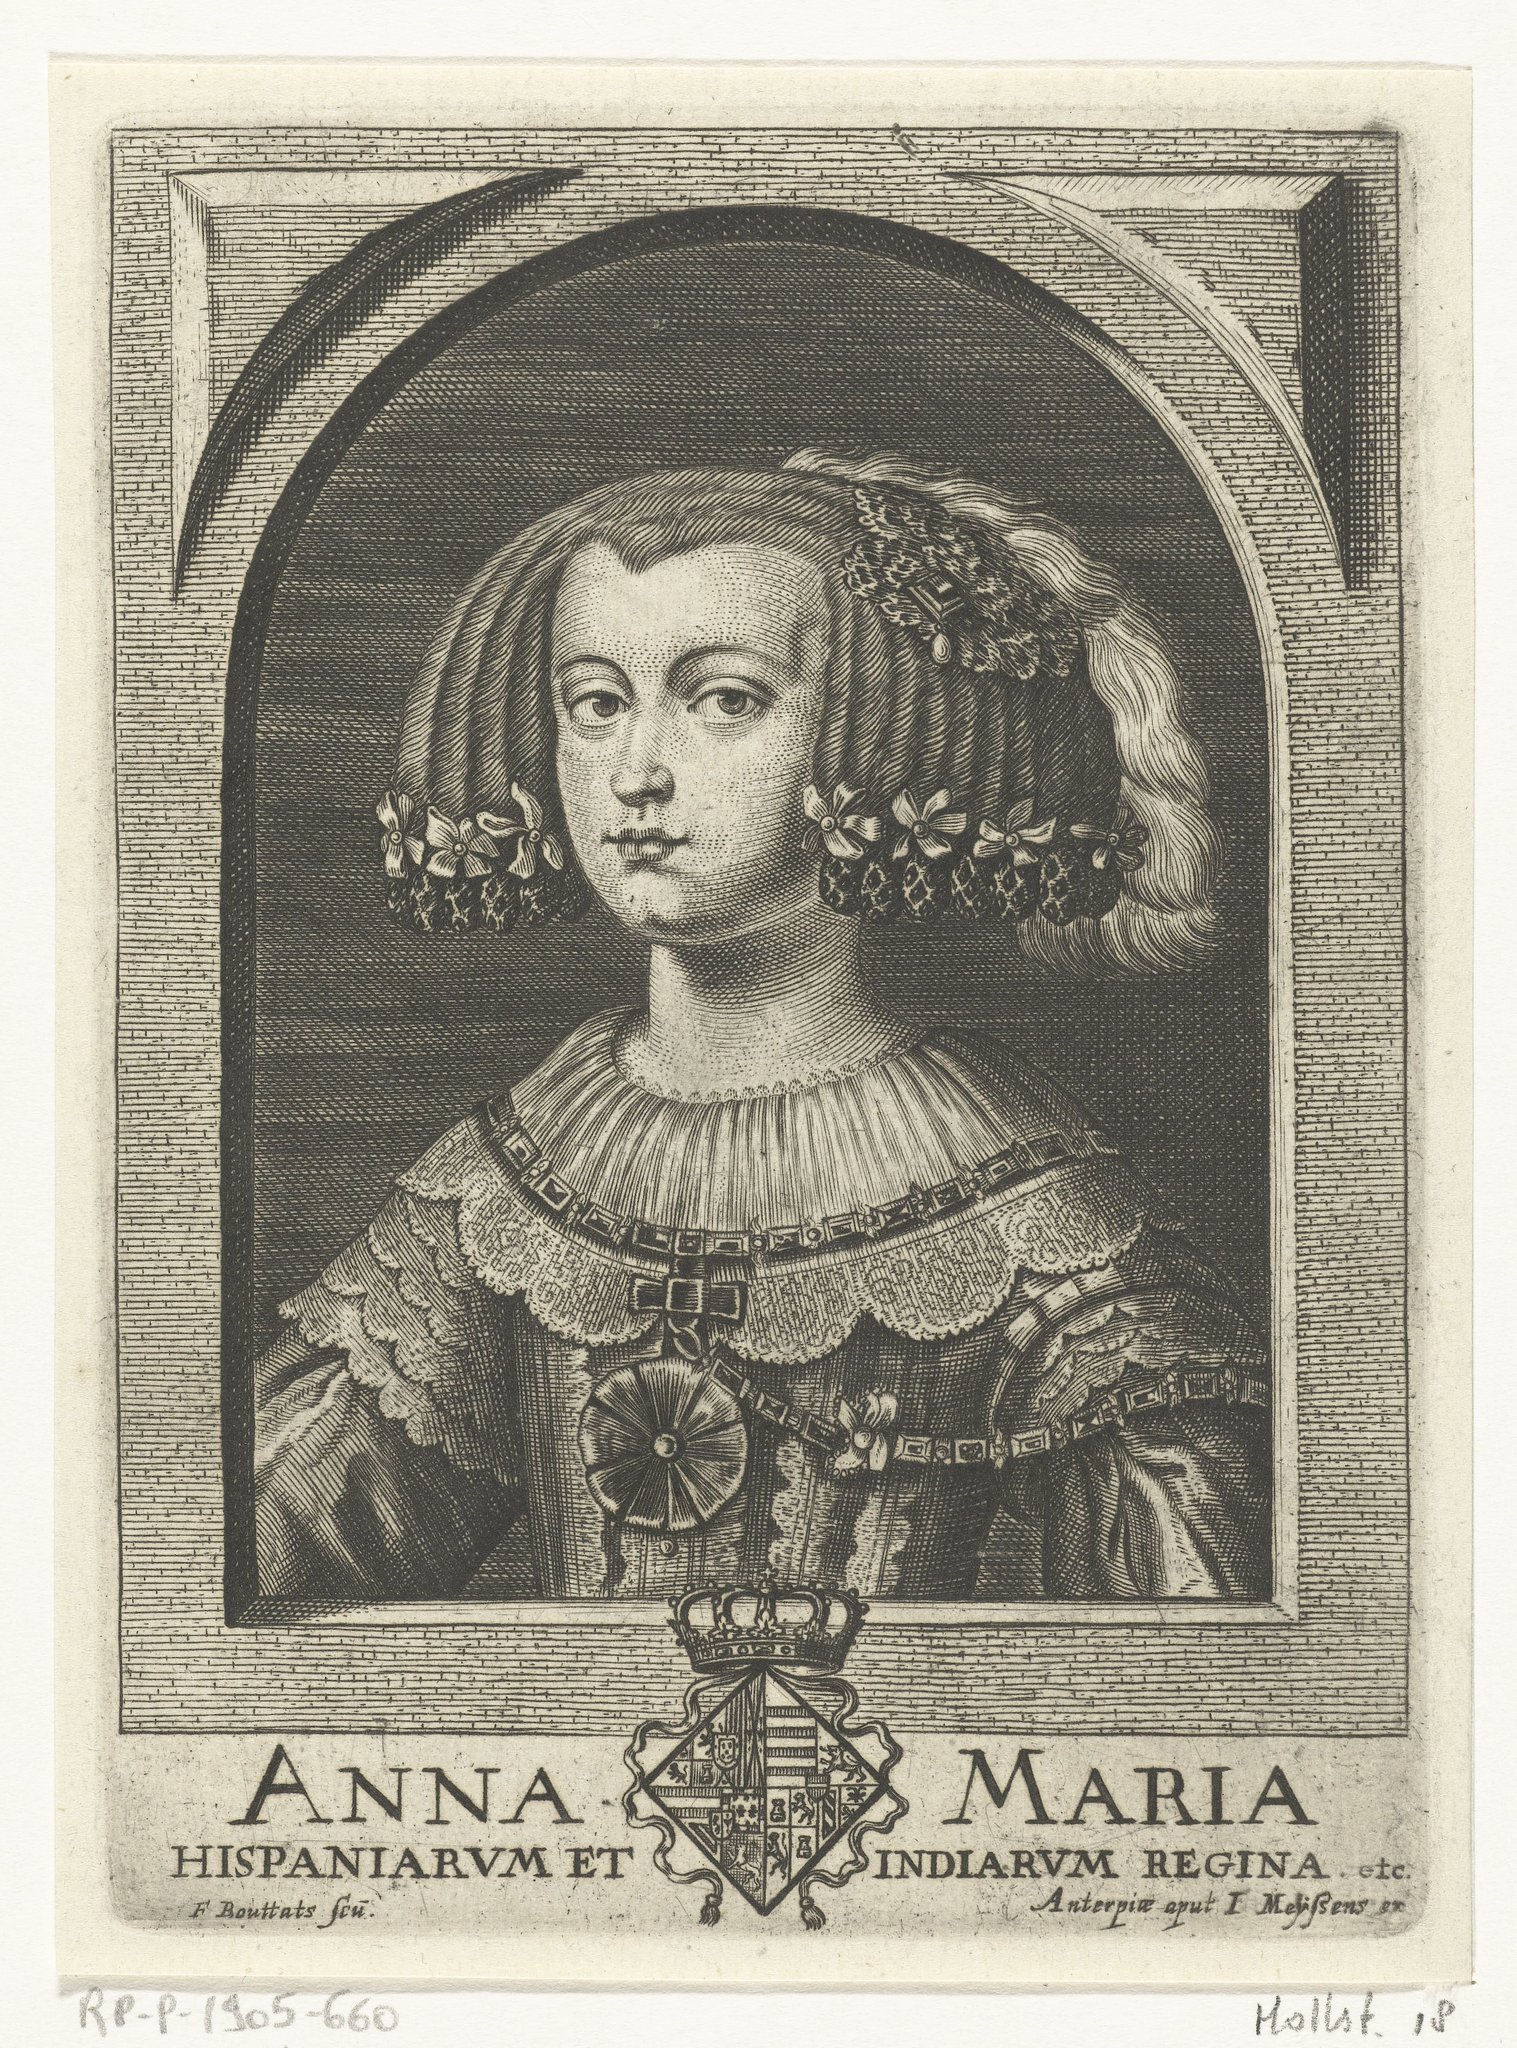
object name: print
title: Anna Maria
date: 1649-1676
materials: paper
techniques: engraving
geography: antwerp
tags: vienna, maria anna van oostenrijk (koningin van spanje)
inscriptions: collector's mark: Lugt 2228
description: Een portret in boogvormige nis van Maria Anna van Oostenrijk, koningin van Spanje. Buste naar links. Onder het portret een Latijns onderschrift met de naam van de geportretteerde.